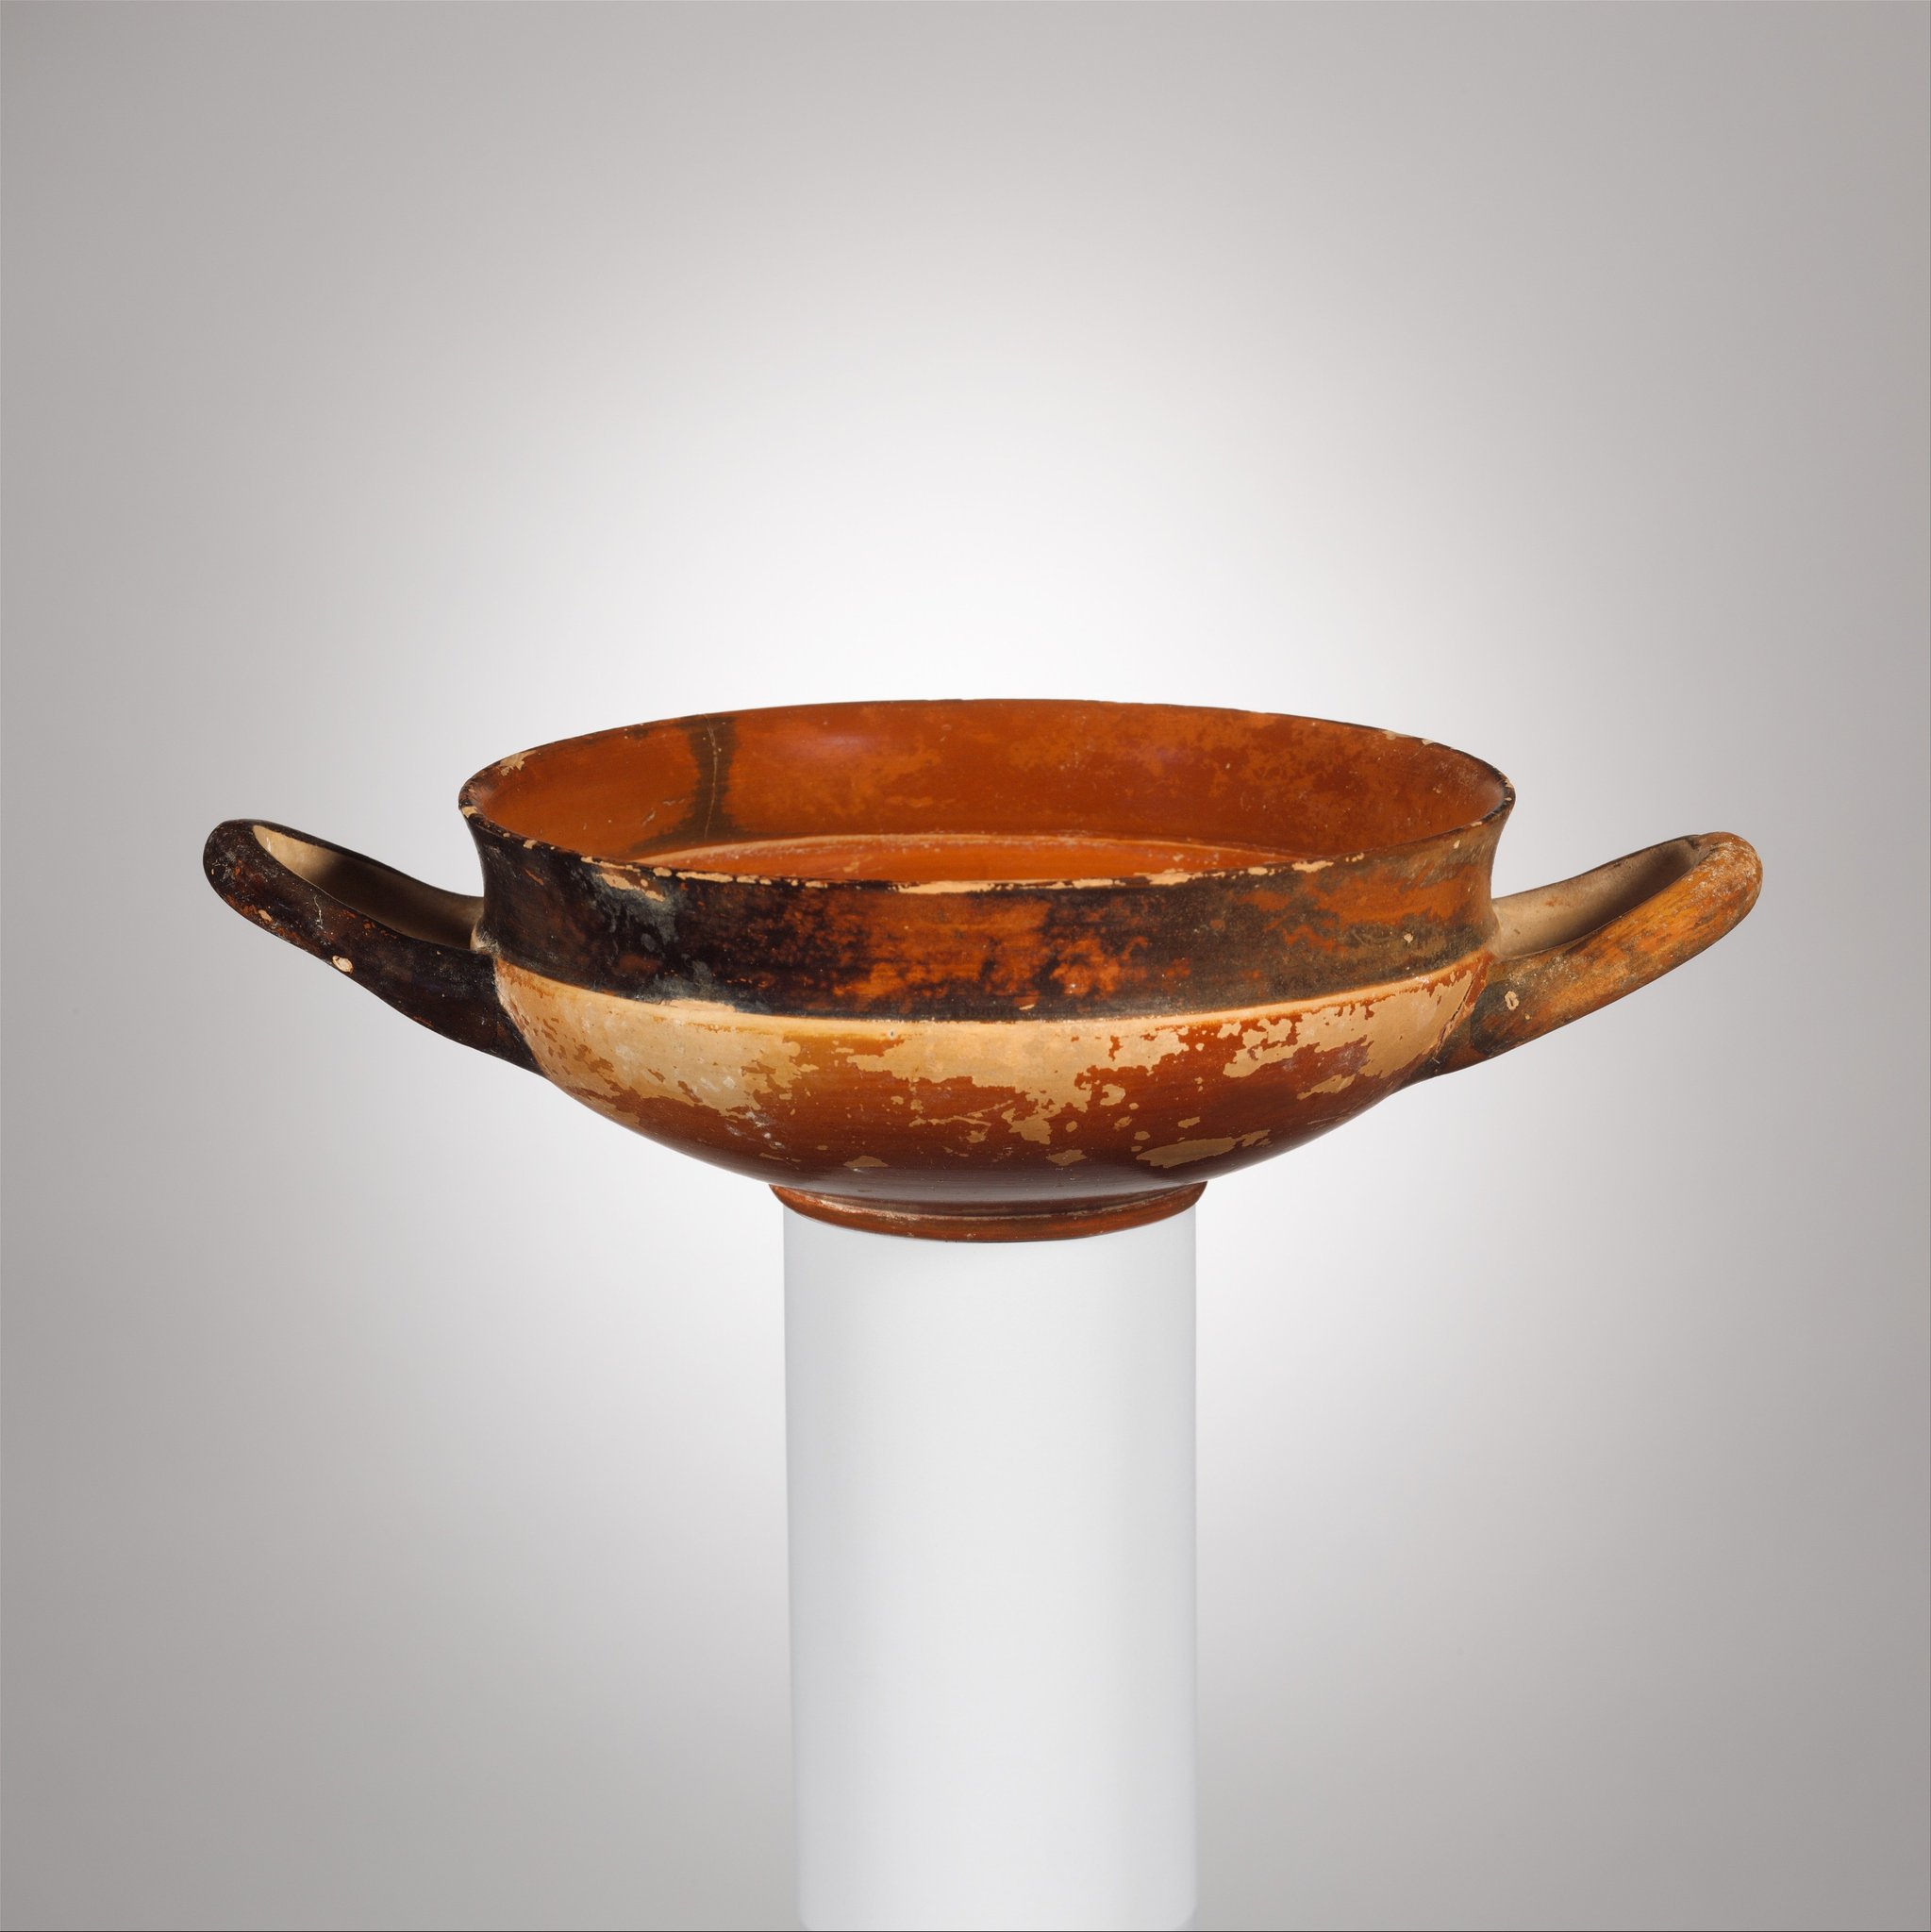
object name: kylix, stemless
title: Terracotta stemless kylix (drinking cup)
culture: greek, attic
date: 500-475 BCE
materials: terracotta